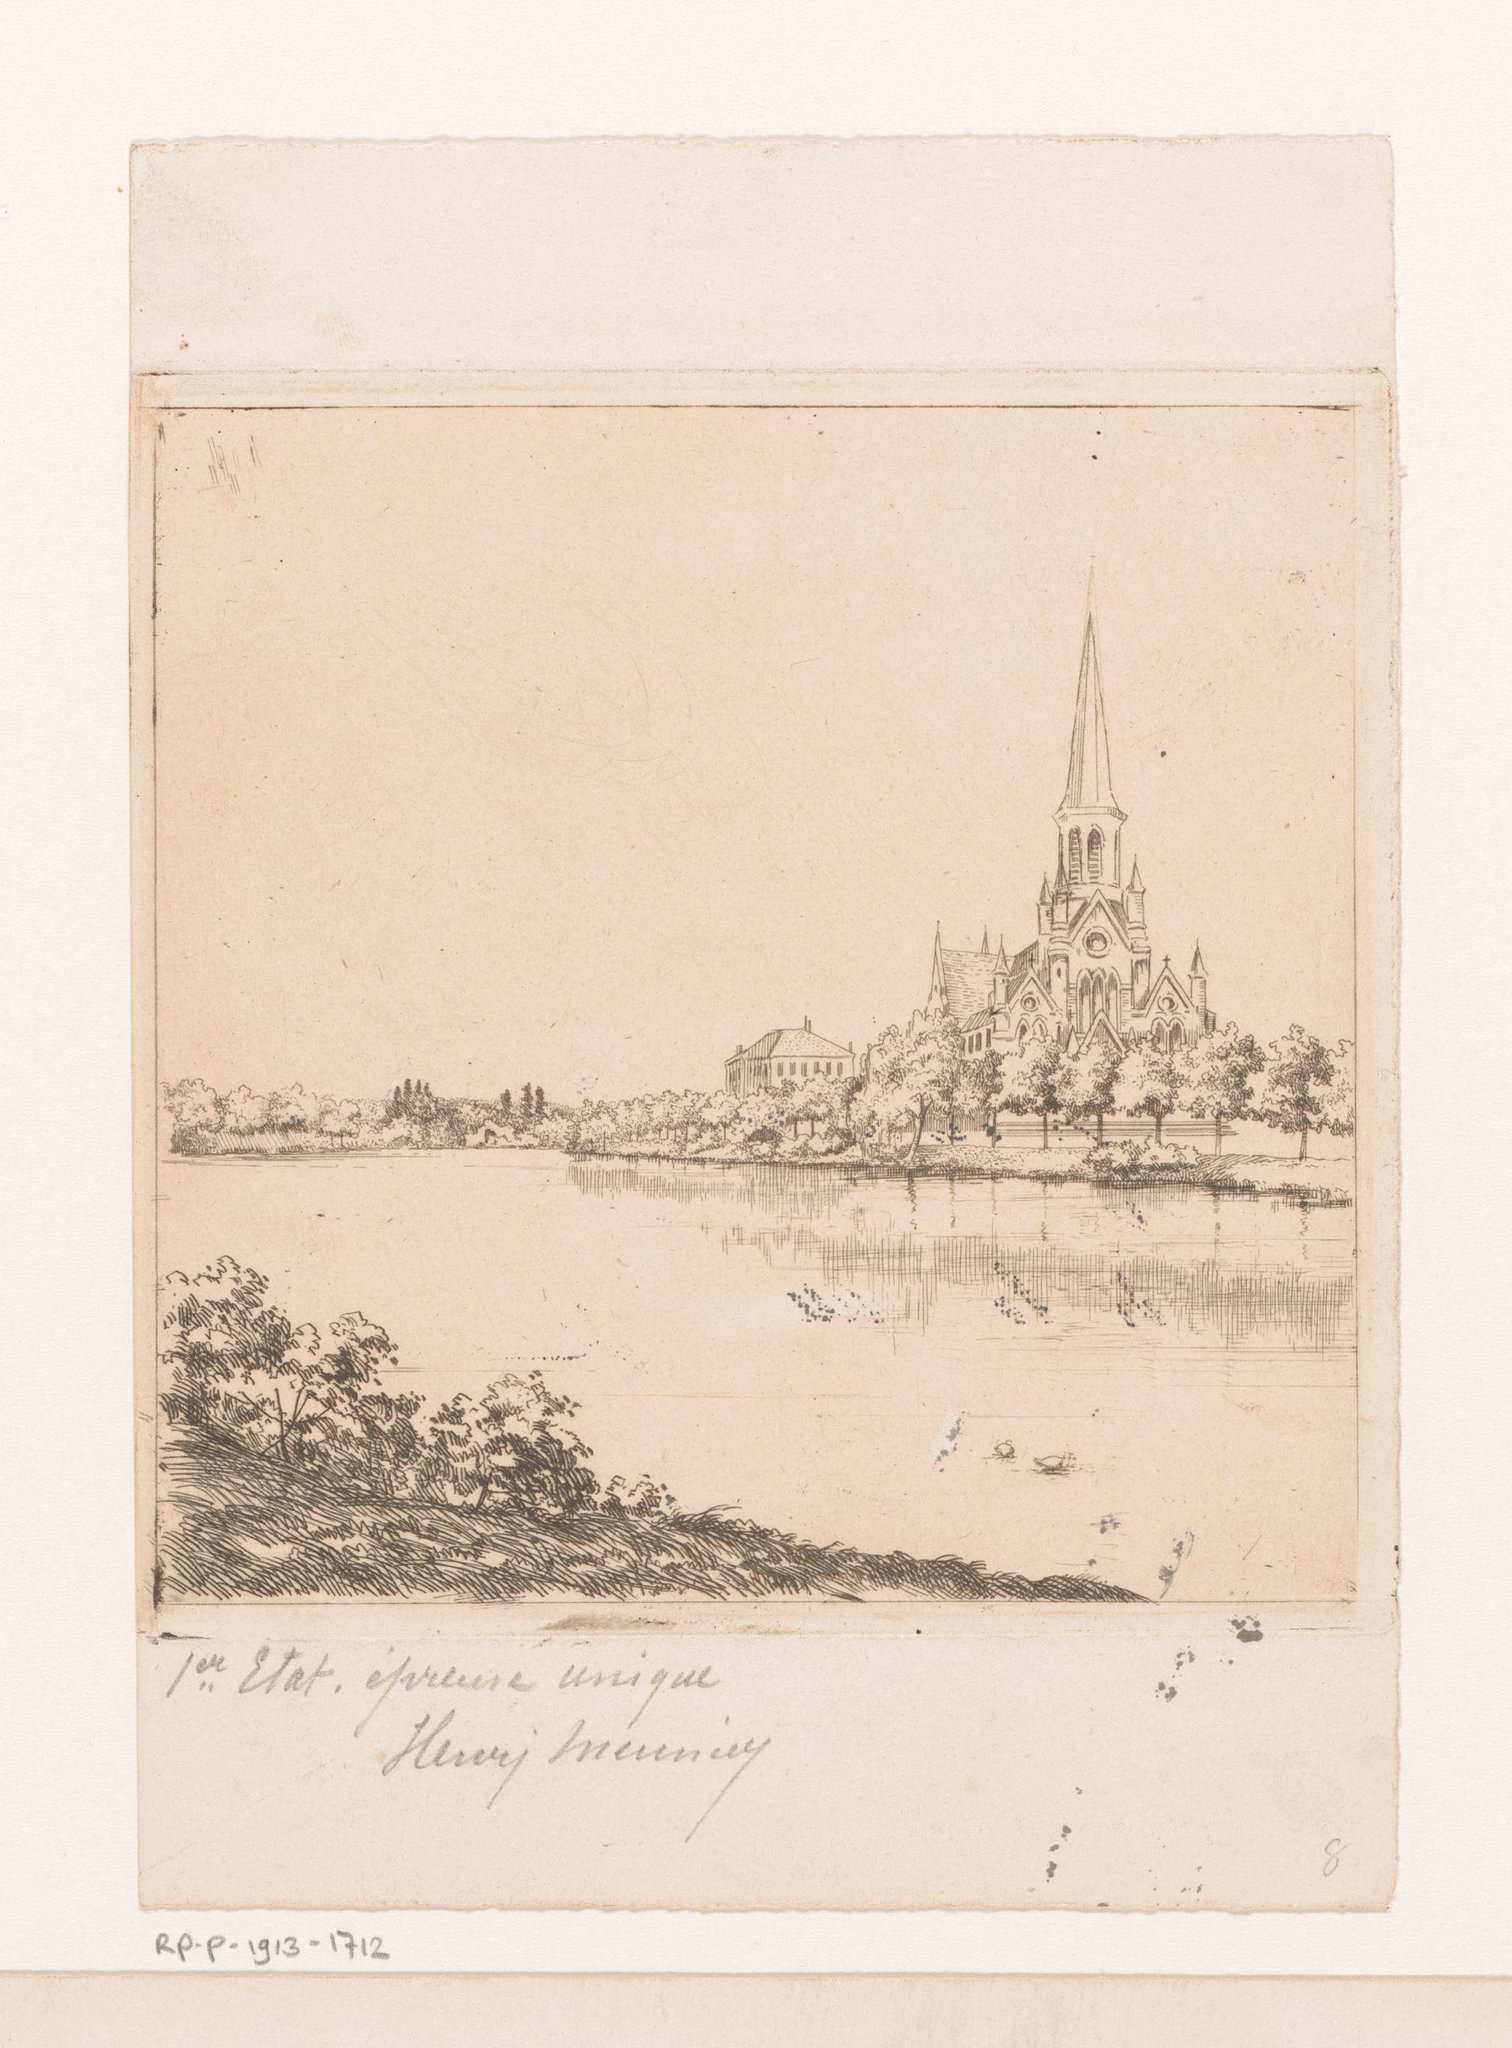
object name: print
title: Gezicht op de vijvers van Elsene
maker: marc henry meunier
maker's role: print maker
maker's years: 1873-1922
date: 1883-1913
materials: paper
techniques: etching, intaglio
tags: church (exterior), canals, waters (in city), pond, pool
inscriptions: collector's mark: Lugt 2228, inscription: ‘1er Etat, épreuve unique’